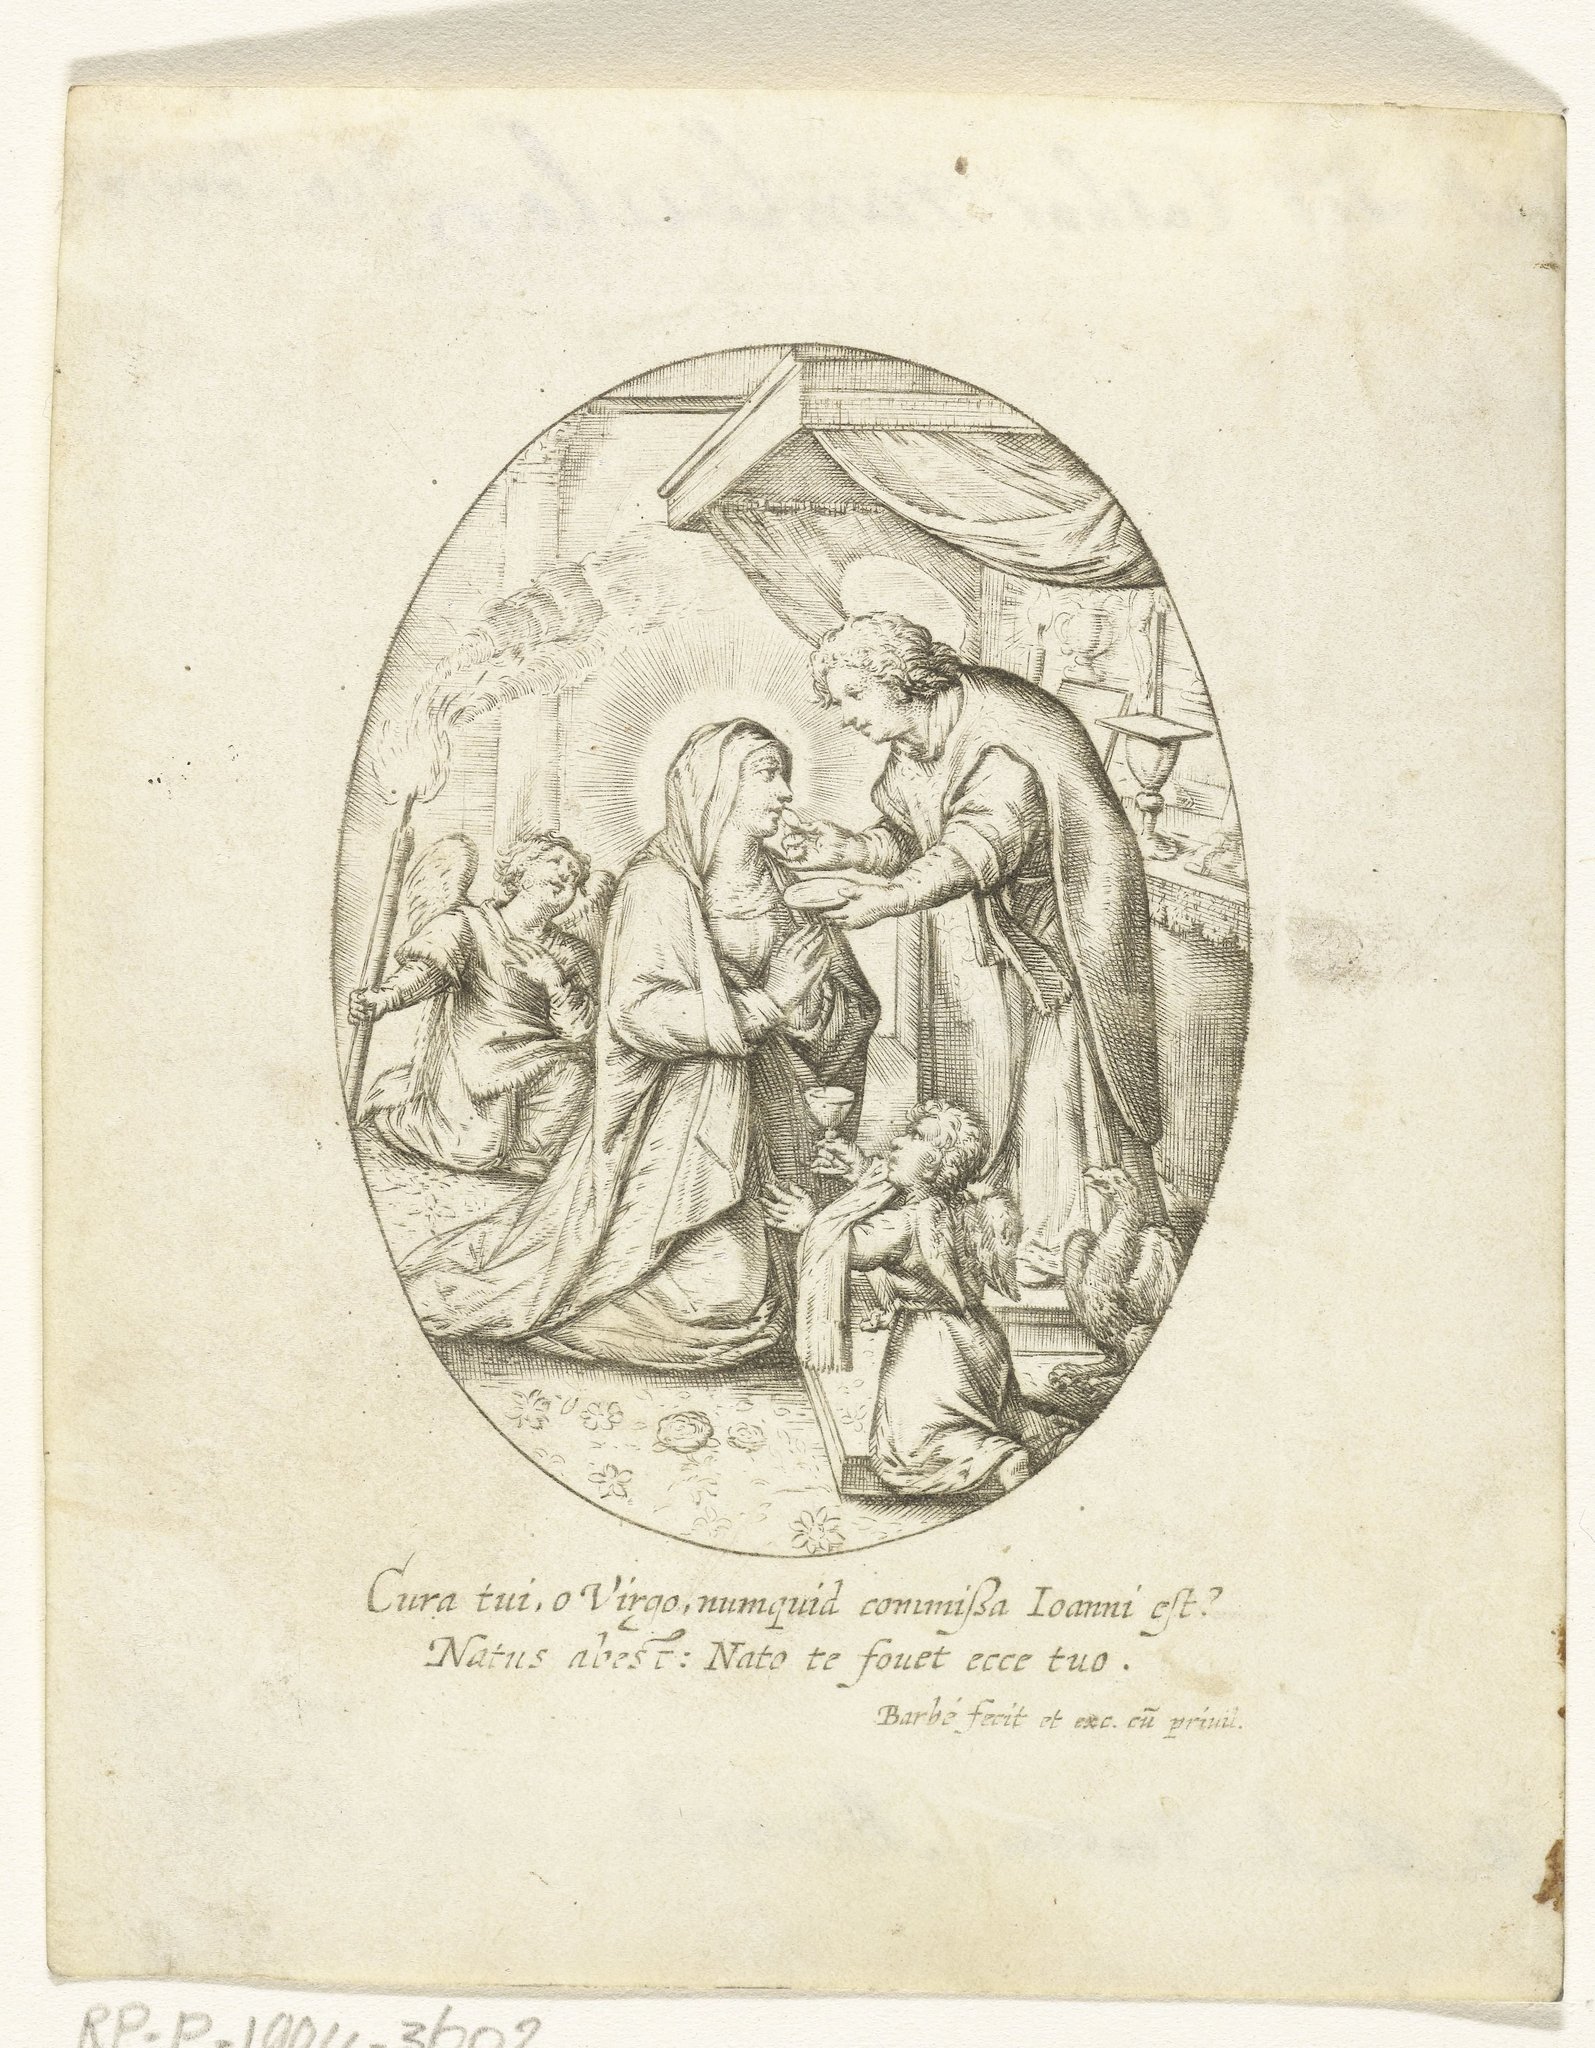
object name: print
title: Johannes de Evangelist bedient Maria de communie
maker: jan-baptist barbé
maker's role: print maker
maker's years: 1578-1649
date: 1588-1648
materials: parchment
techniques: engraving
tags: mary receives her last communion from john the evangelist or from christ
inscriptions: inscription: ‘Maria Cathar: van Ceulen’, collector's mark: Lugt 2228, inscription: ‘P.F.A. Heeren Minorita Catechista ita est’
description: Maria zit geknield en ontvangt haar laatste communie uit handen van Johannes de Evangelist. De Latijnse tekst onder de ovale voorstelling beschrijft deze gebeurtenis.